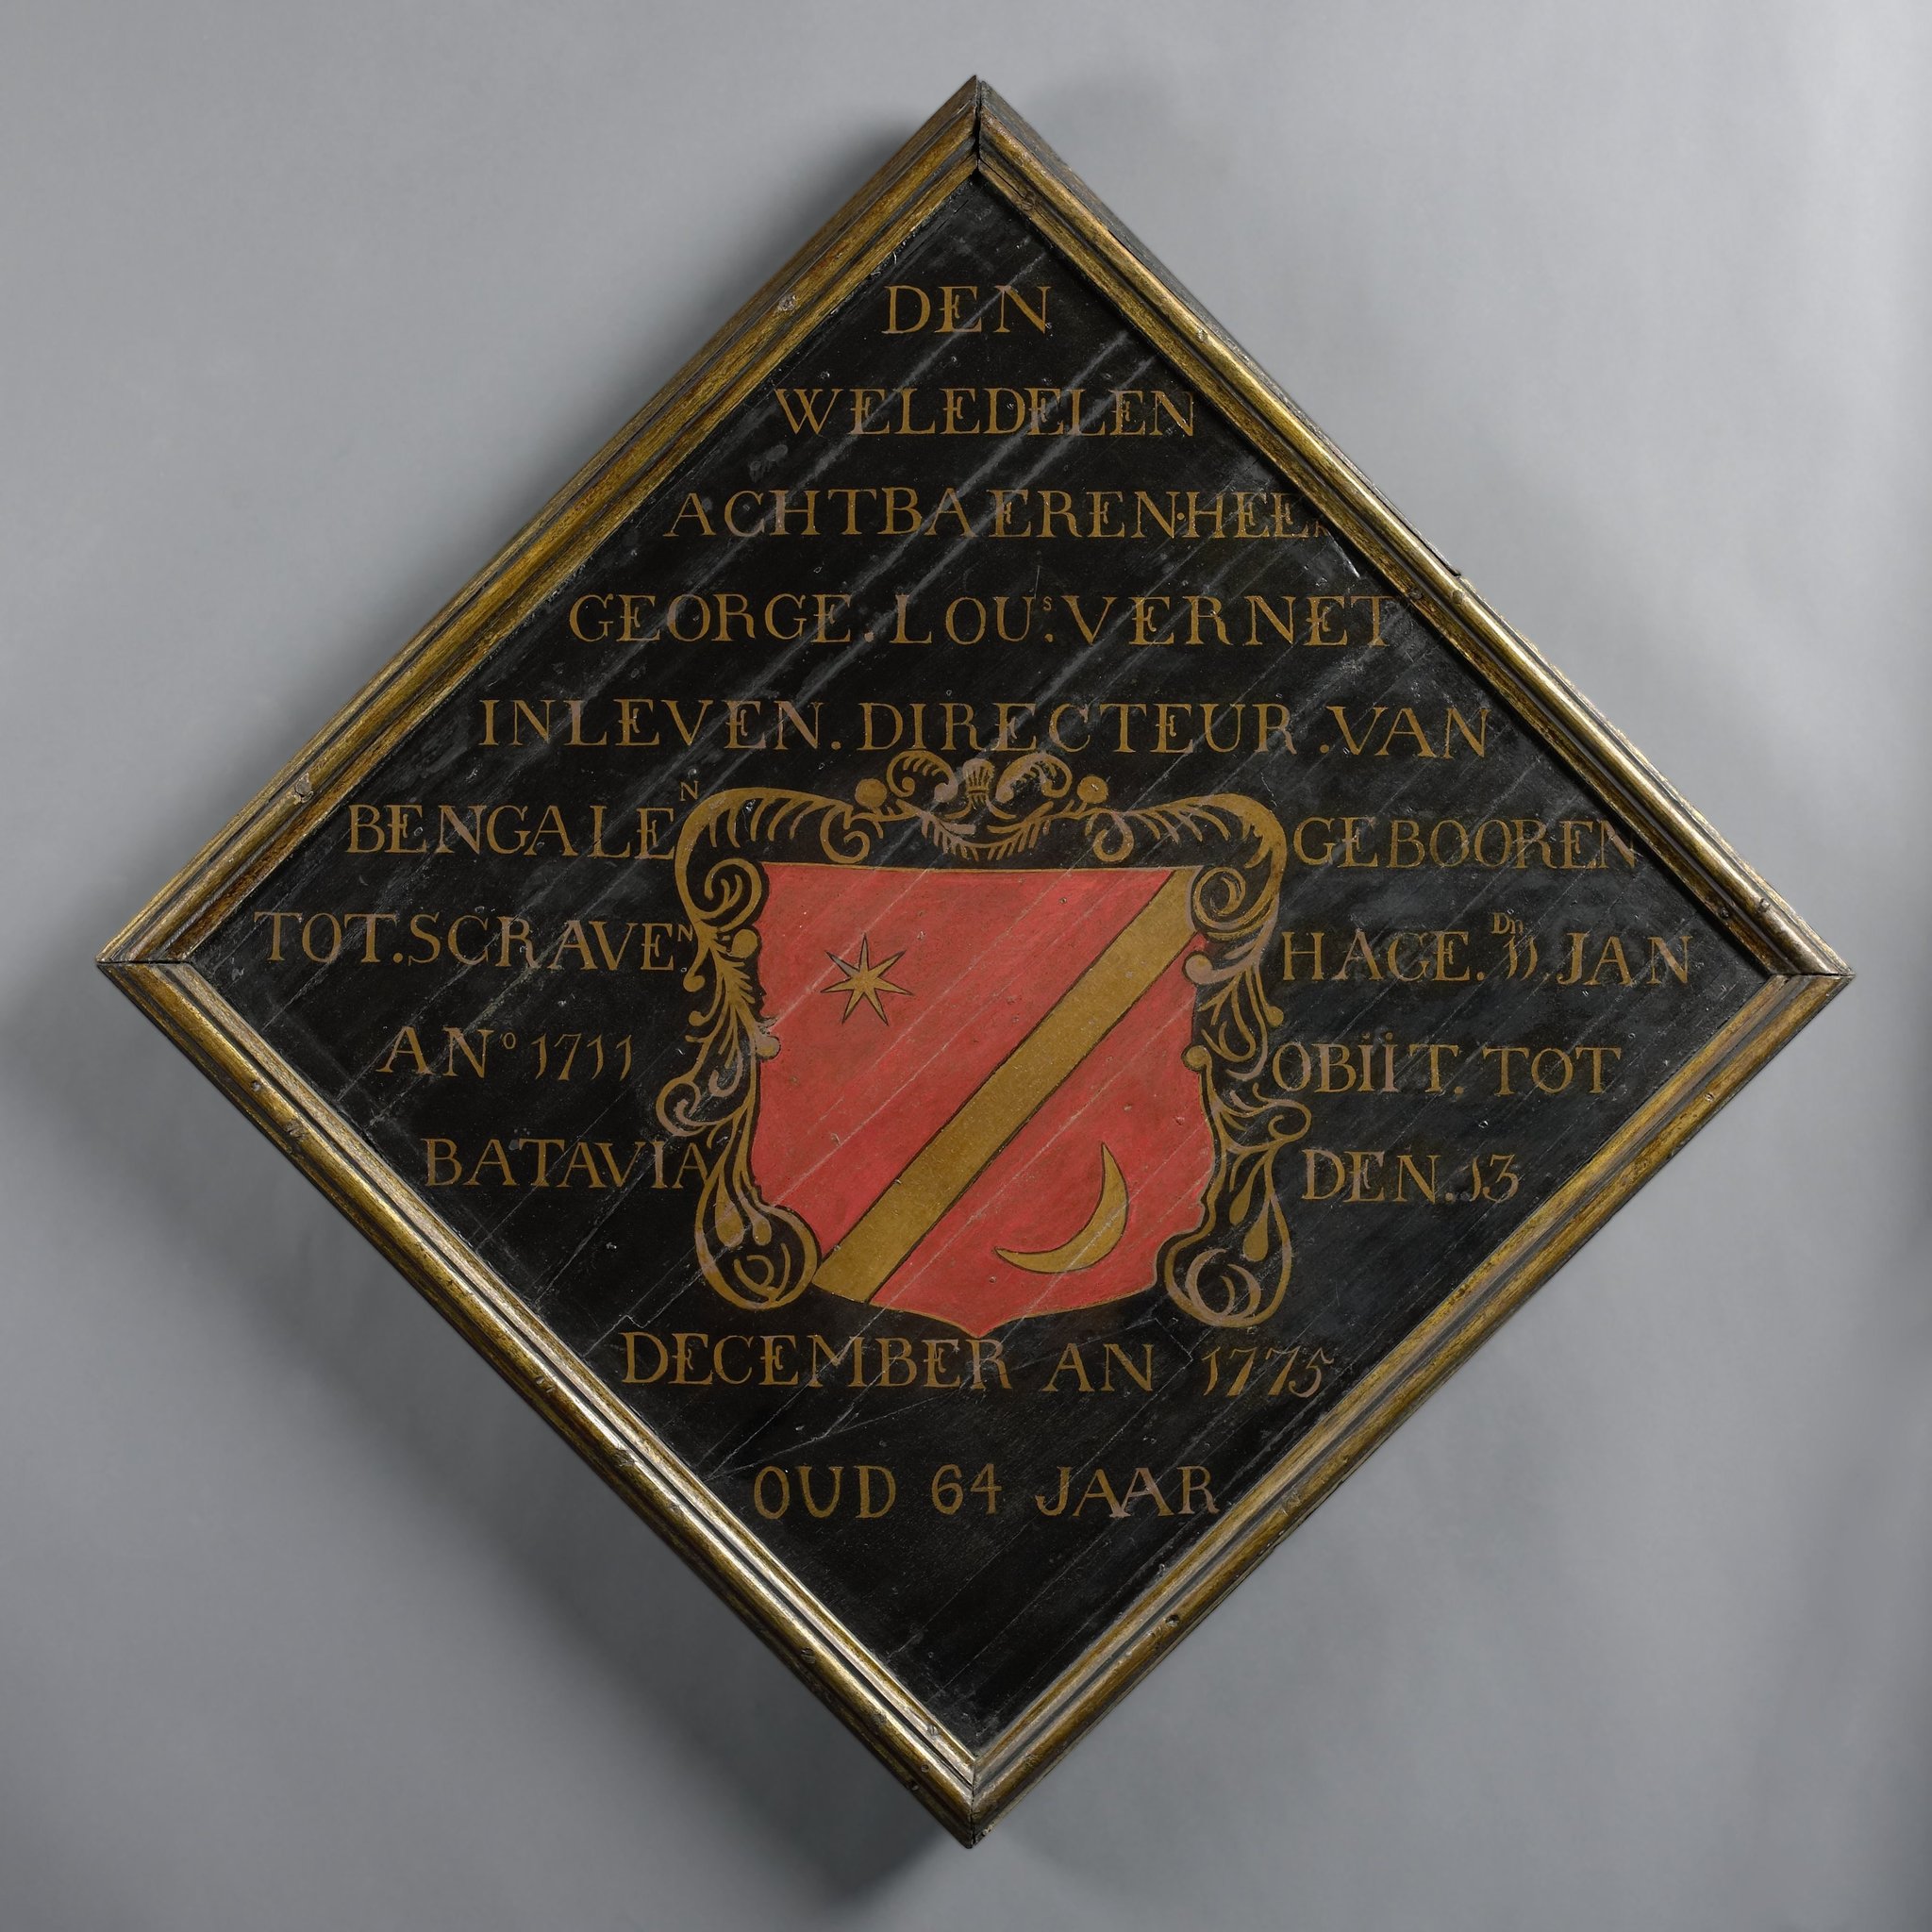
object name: rouwbord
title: Grafbord van George Lodewijk Vernet (1711-75), directeur van Bengalen (1763-69)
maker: Anonymous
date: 1775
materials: panel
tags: the hague, batavia, armorial bearing, heraldry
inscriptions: : ‘Den Weledelen Achtbaeren Heer George Lous Vernet. In leven Directeur van Bengalen Gebooren tot scraven Hage Dn 11 Jan Ano 1711 Obiit to Batavia Den 13 December An 1775 oud 64 Jaar’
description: Epitaph from the church in Chinsura, second half 18th century. Chinsura in Bengal (Northeast India) was one of the key trading posts of the VOC. Under its director, George Louis Vernet, a church was built at Chinsura in 1767. As was traditional in European churches, memorials were placed on the walls to commemorate high-ranking officials who had died in Asia in the service of the Company. Far right: Vernet's epitaph - the director died in Batavia in 1775. The second from the left is the epitaph of Theodora Hendrica Piekenbroek. She was the daughter of a Dutch preacher from Batavia. After marrying Boudewijn Versewel Faure - whose memorial is also shown here - she moved to Chinsura, where they both died within a short space of time. Theodora was only 23: the death rate among Europeans in Bengal was high.